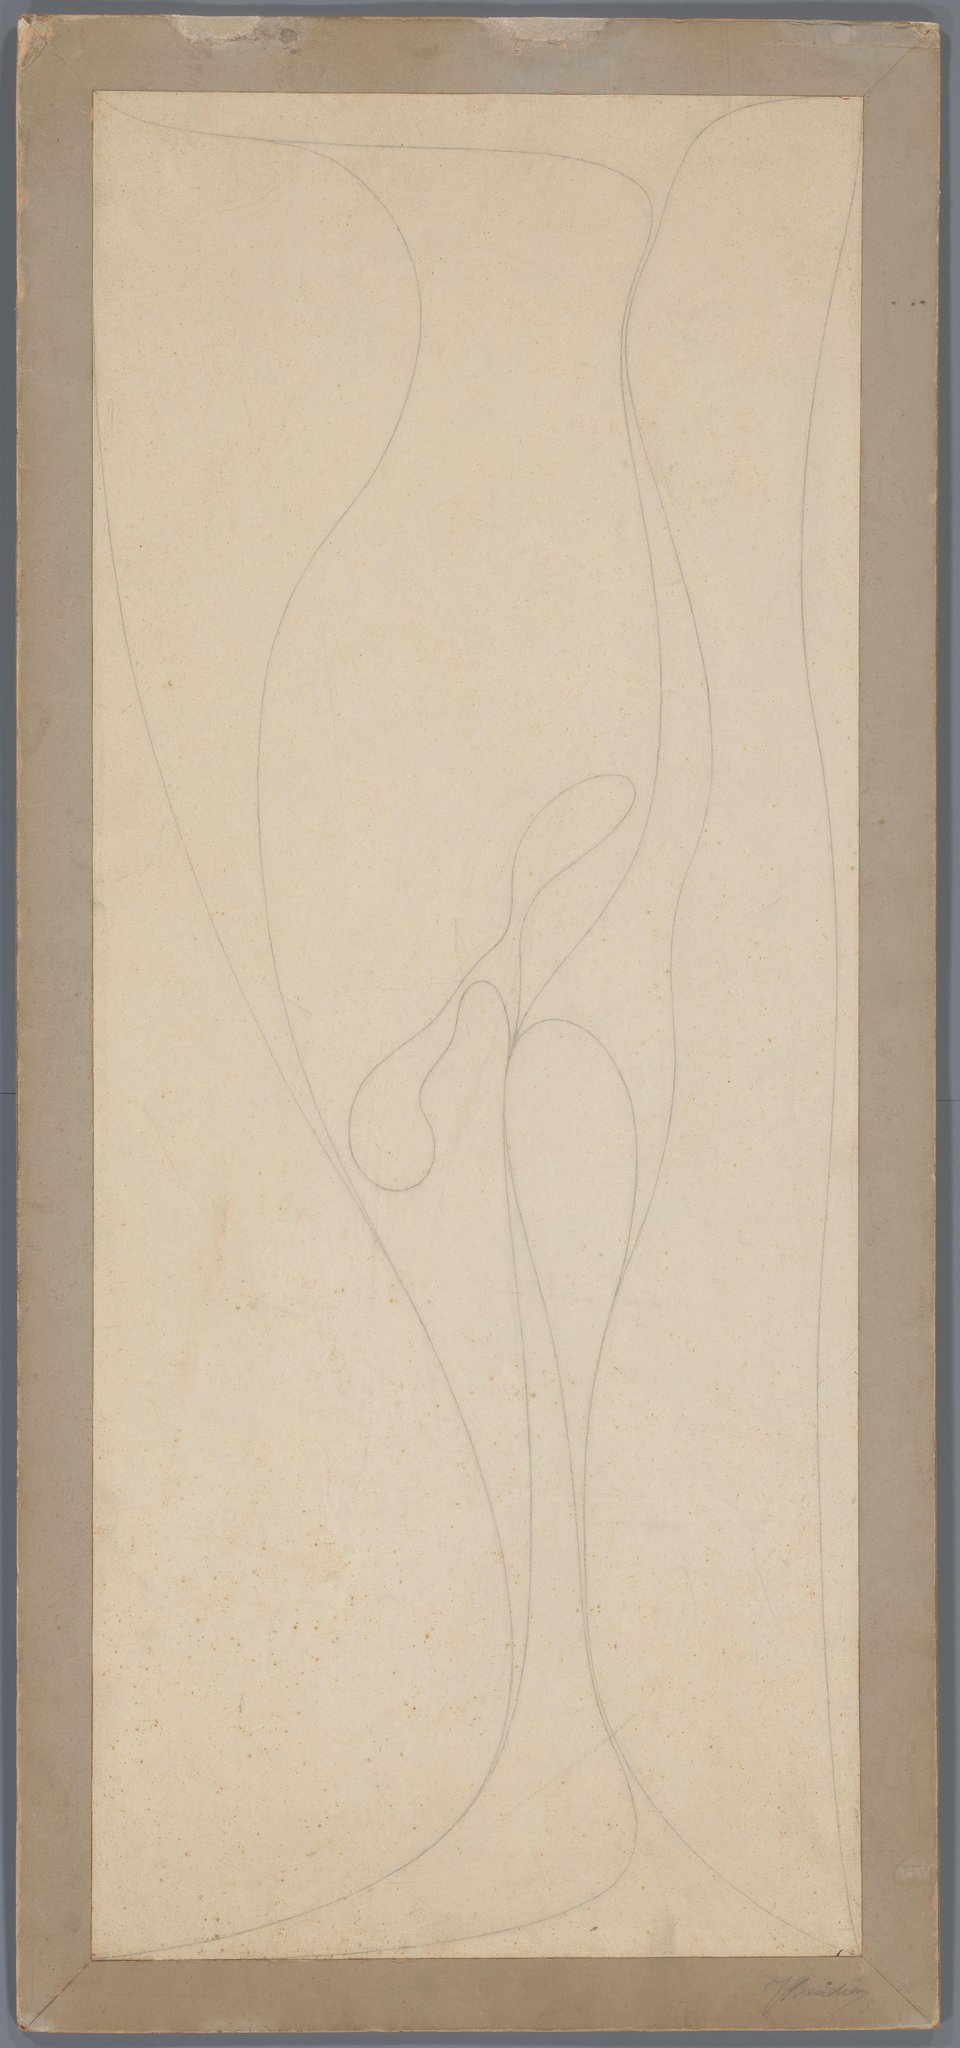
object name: drawing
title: Meditistic Arabesque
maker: jacob bendien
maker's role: draughtsman, print maker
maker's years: 1890-1933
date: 1910-1930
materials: cardboard, paper, pencil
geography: netherlands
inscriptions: signature: ‘J Bendien’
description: Around 1913, Jacob Bendien and several other Dutchmen developed their own form of entirely abstract art. They presented it in Amsterdam as ‘absolute art’, derived from the ‘absolute music’ – music not explicitly about anything – that was making its appearance at the time. In his work Bendien strove for what he called ‘Meditism’, an expression of emotions that was controlled by the mind.